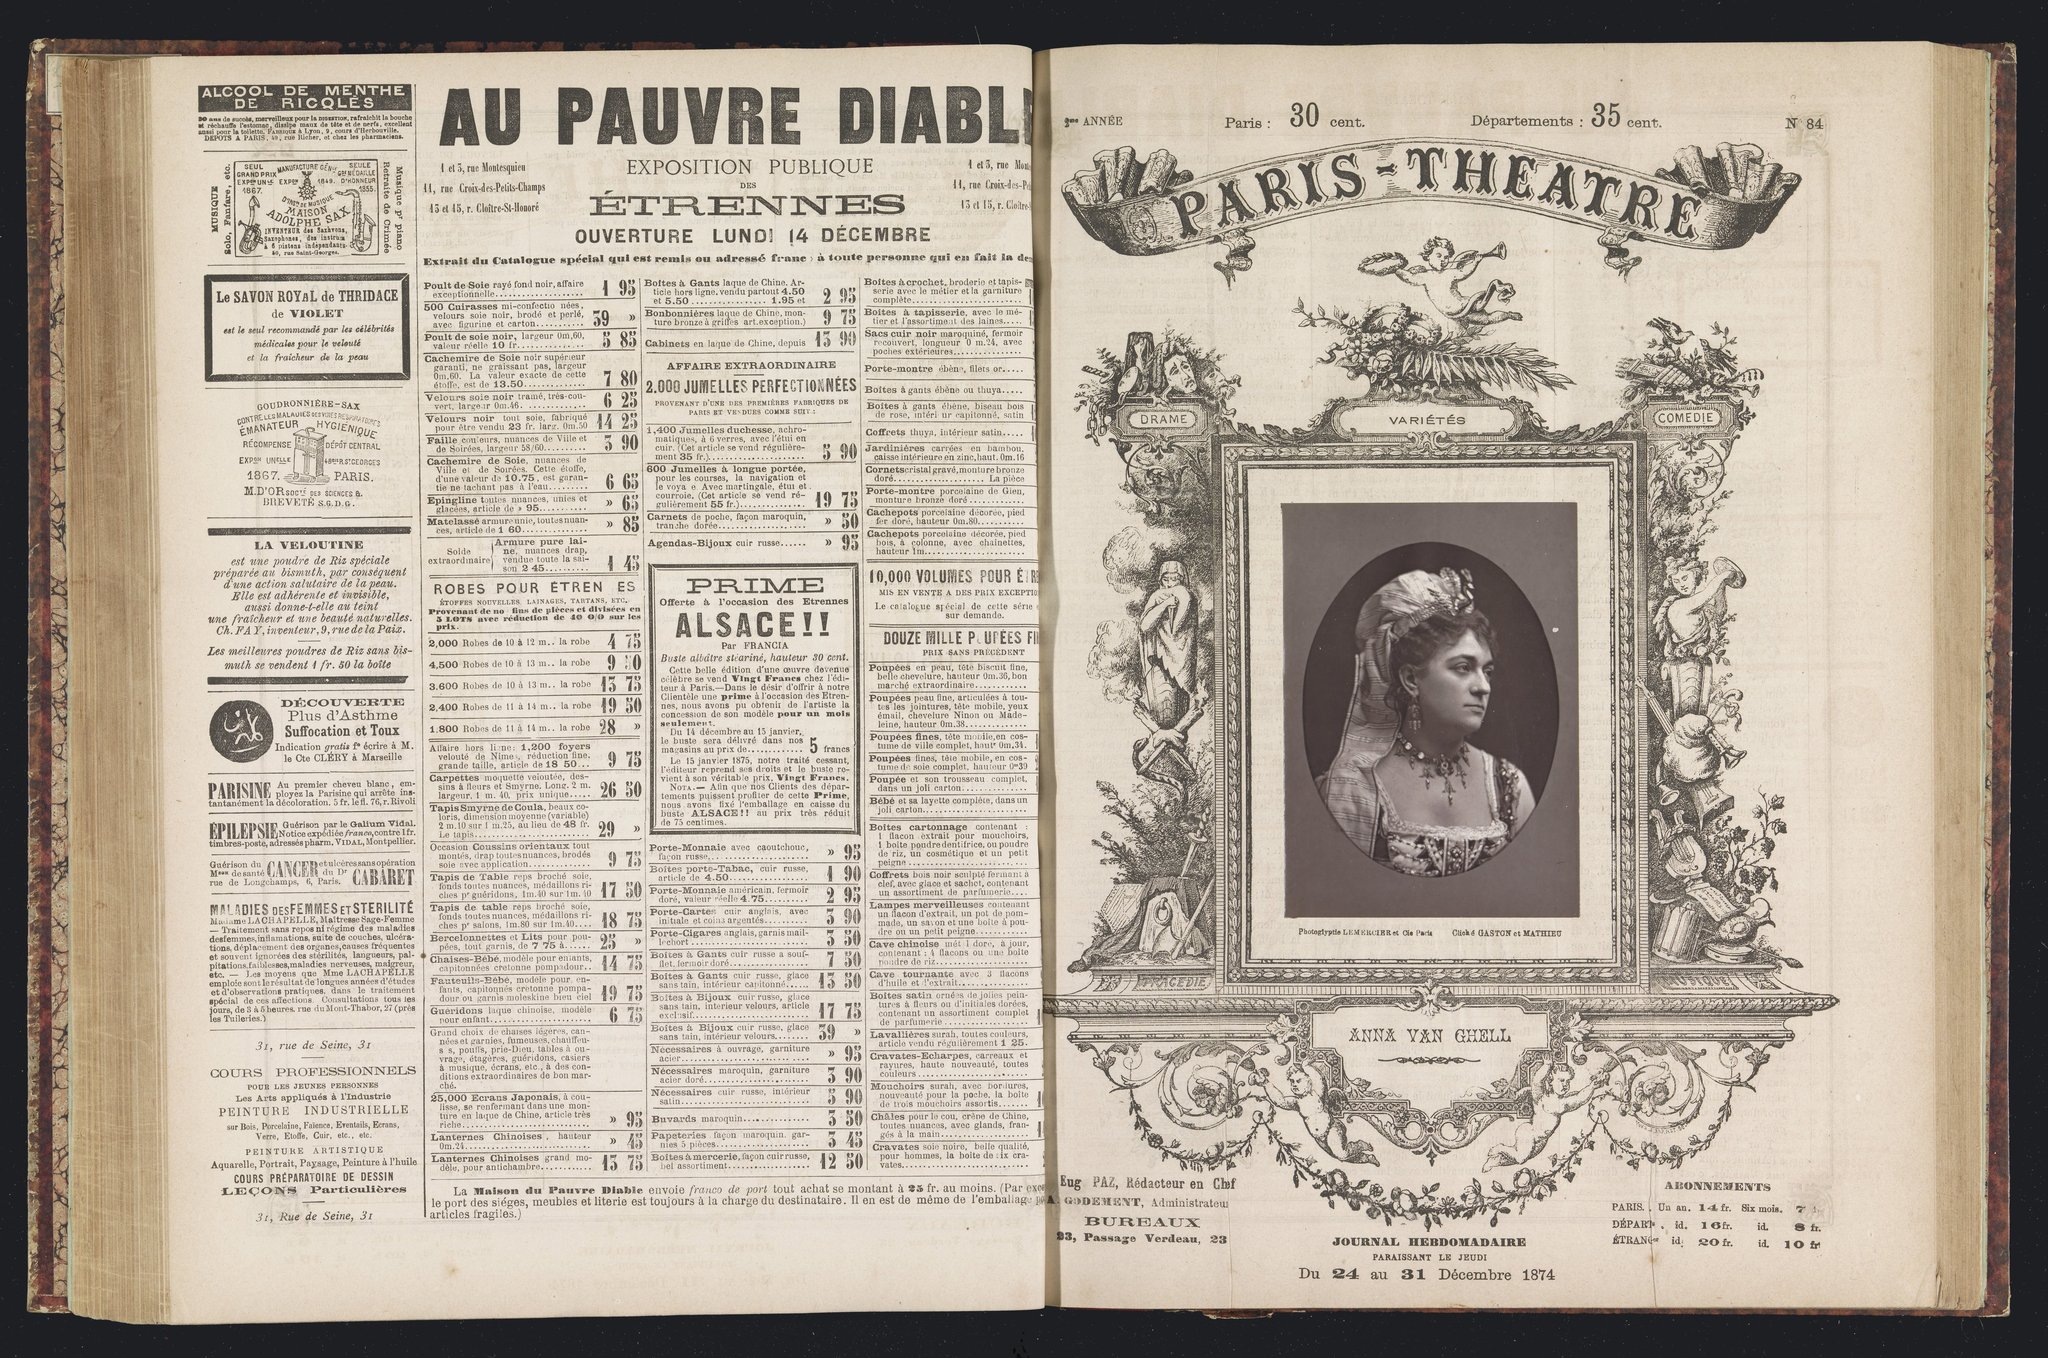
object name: page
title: Portret van Anna Van Ghell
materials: paper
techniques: woodburytype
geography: paris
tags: portrait of opera-singer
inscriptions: inscription: ‘Journal hebdomadaire paraissant le jeudi Du 24 au 31 Décembre 1874’, number: ‘No 84’